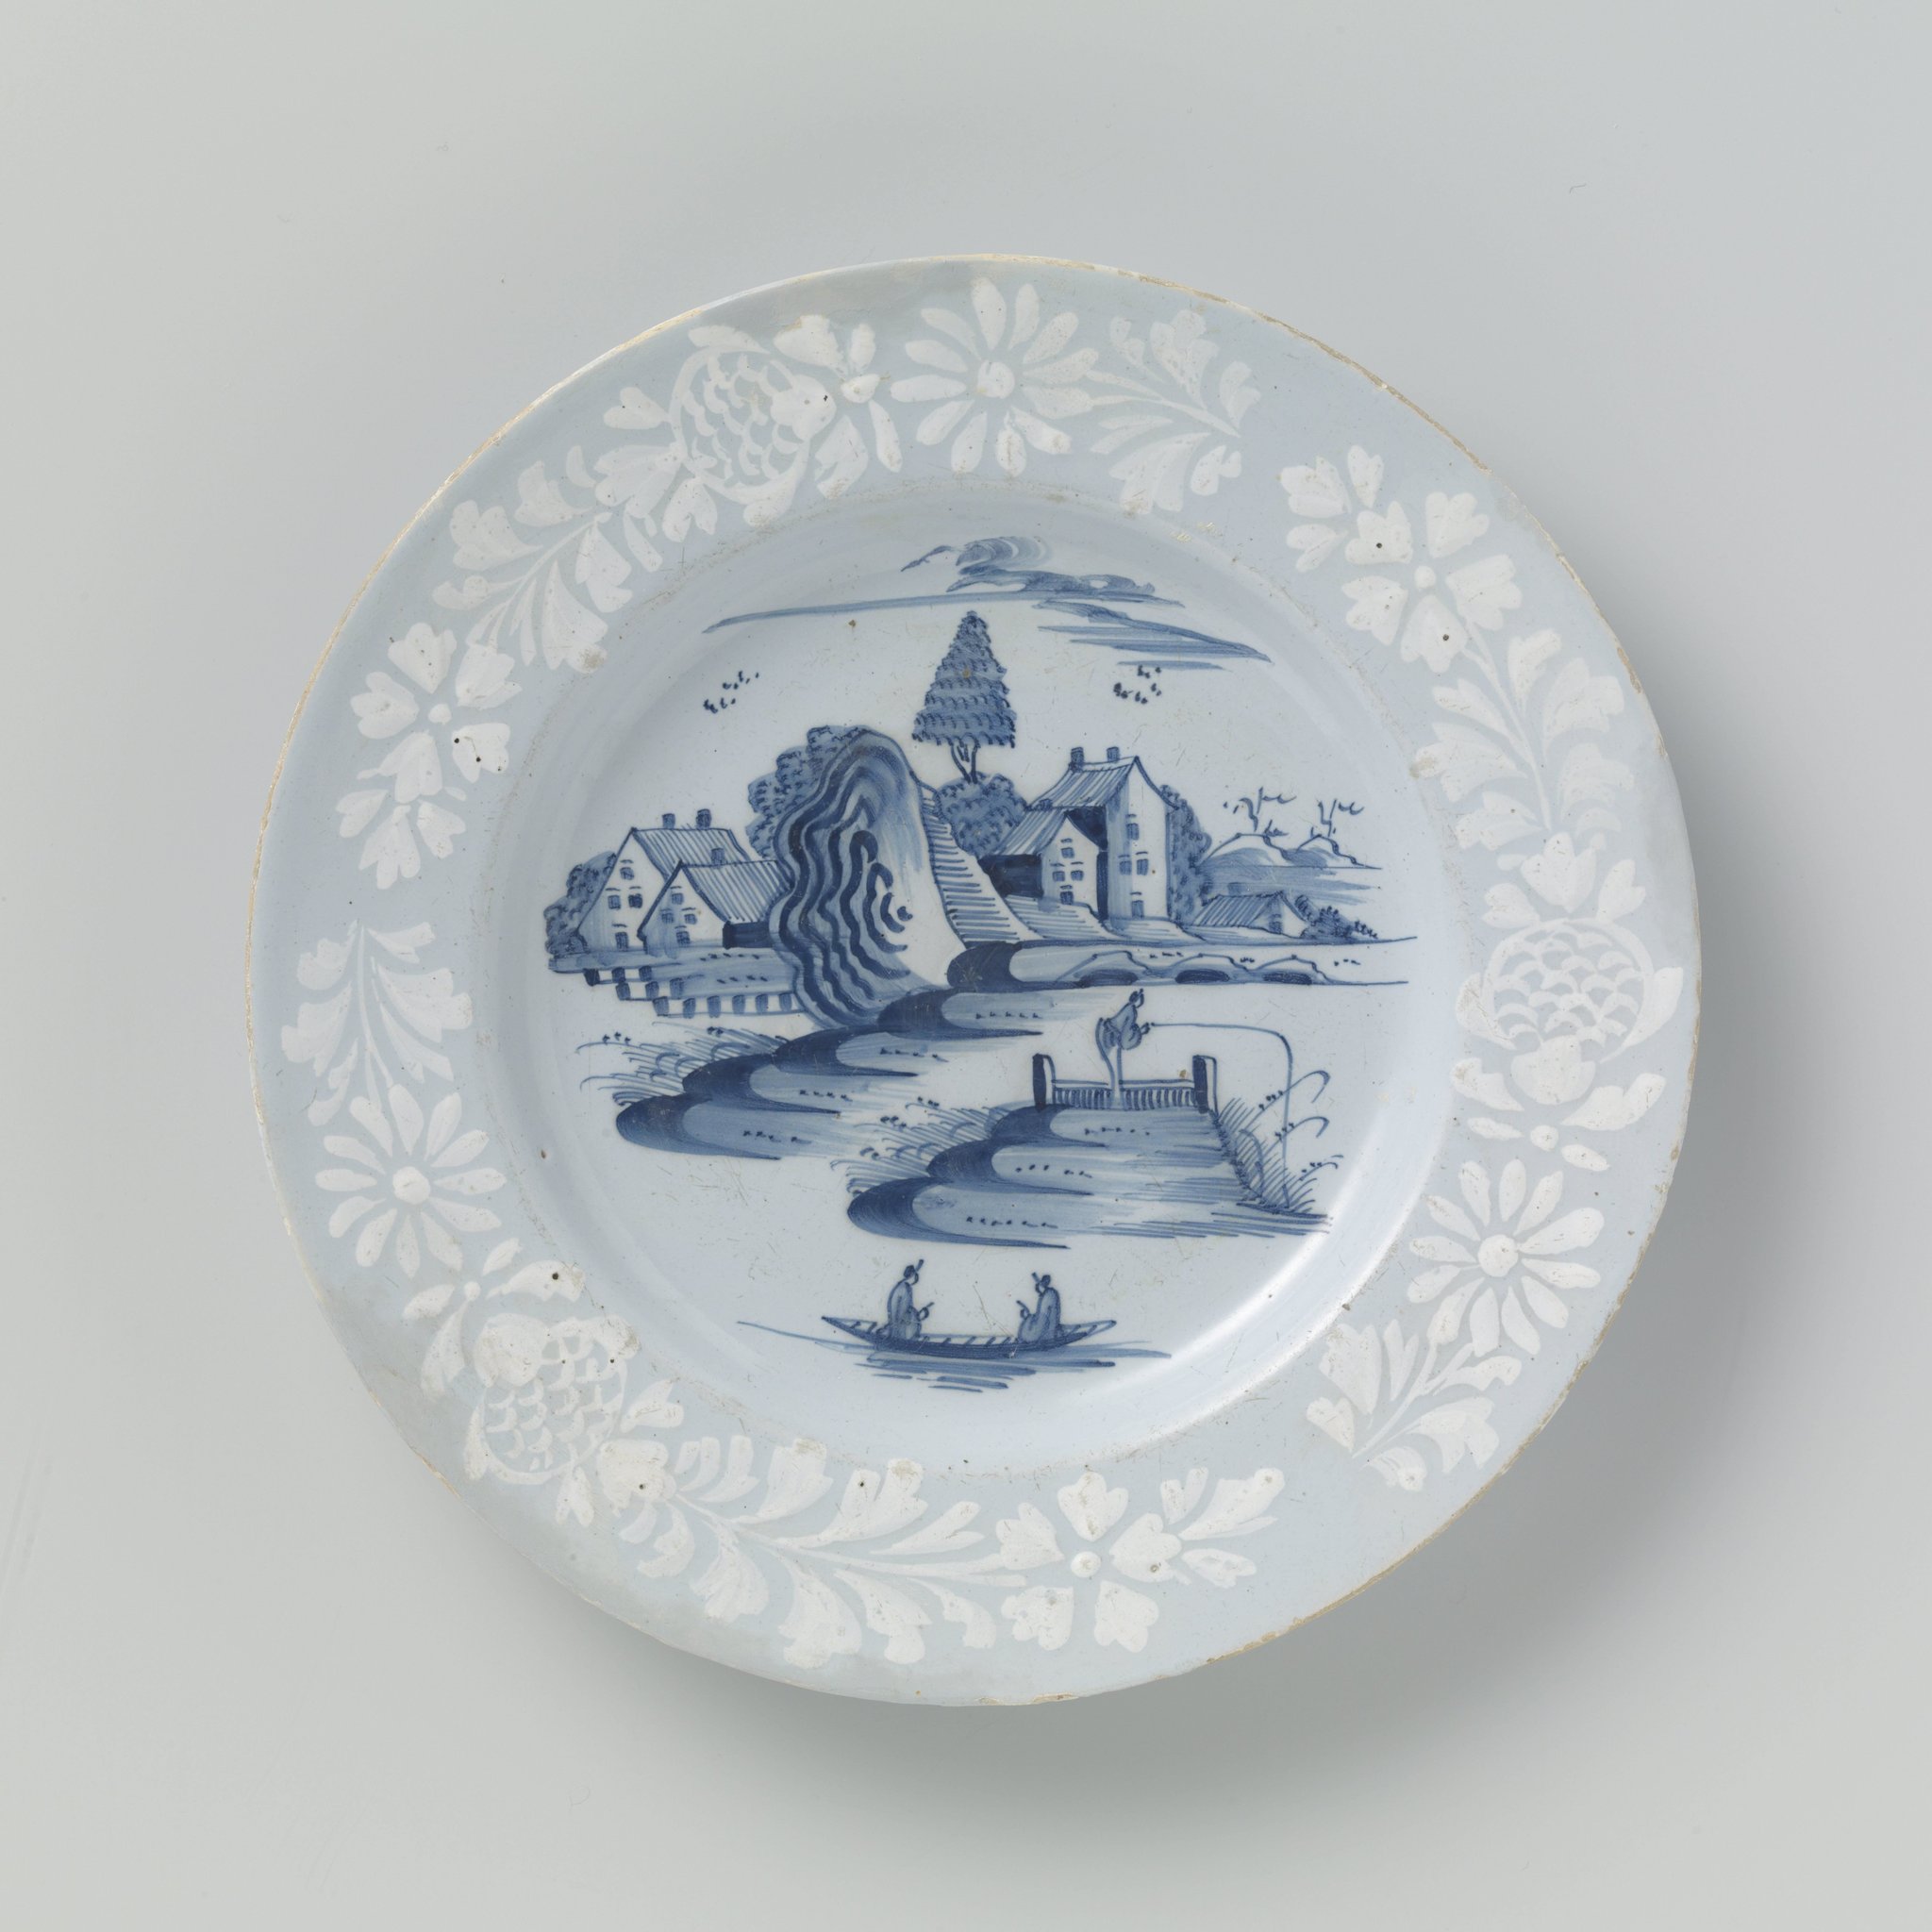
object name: plate dish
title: Bord, het plat beschilderd met een landschap met huizen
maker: Anonymous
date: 1760-1770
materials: earthenware, glaze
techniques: painted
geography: bristol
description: Rond bord van beschilderde faience. Het bord heeft een lichtblauwe fond. Op het plat is in blauw een landschap met huizen geschilderd en op de rand witte bloemen. Bij het bord horen drie identieke borden (BK-NM-11334-A, BK-NM-11334-B en BK-NM-11334-D).